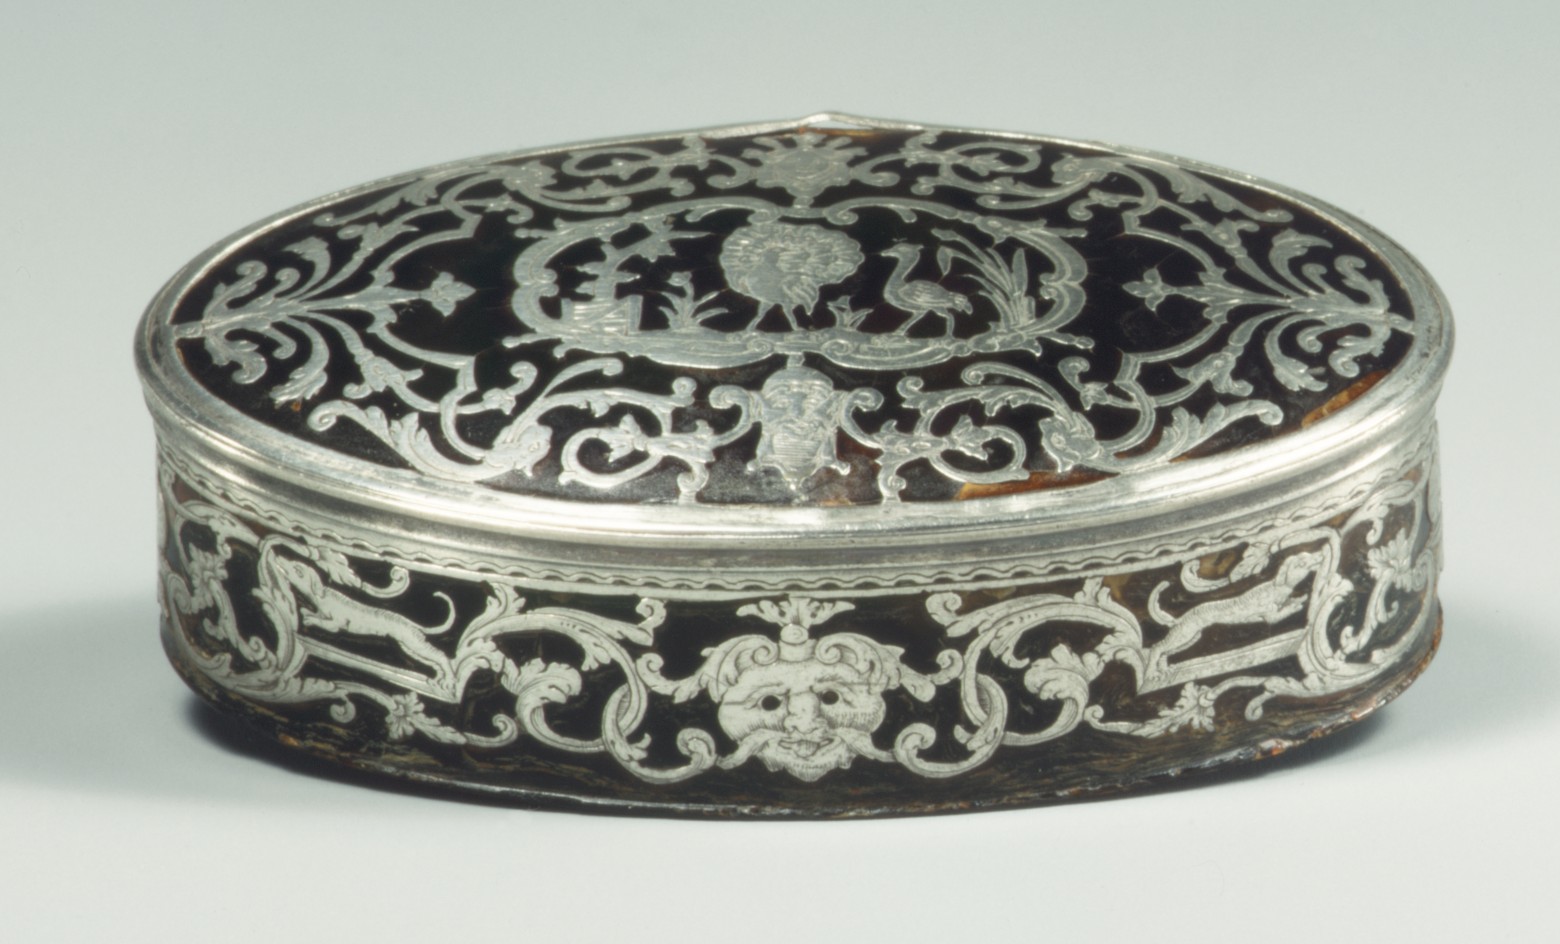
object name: box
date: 1720-1730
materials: silver, shell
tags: grotesques,dogs